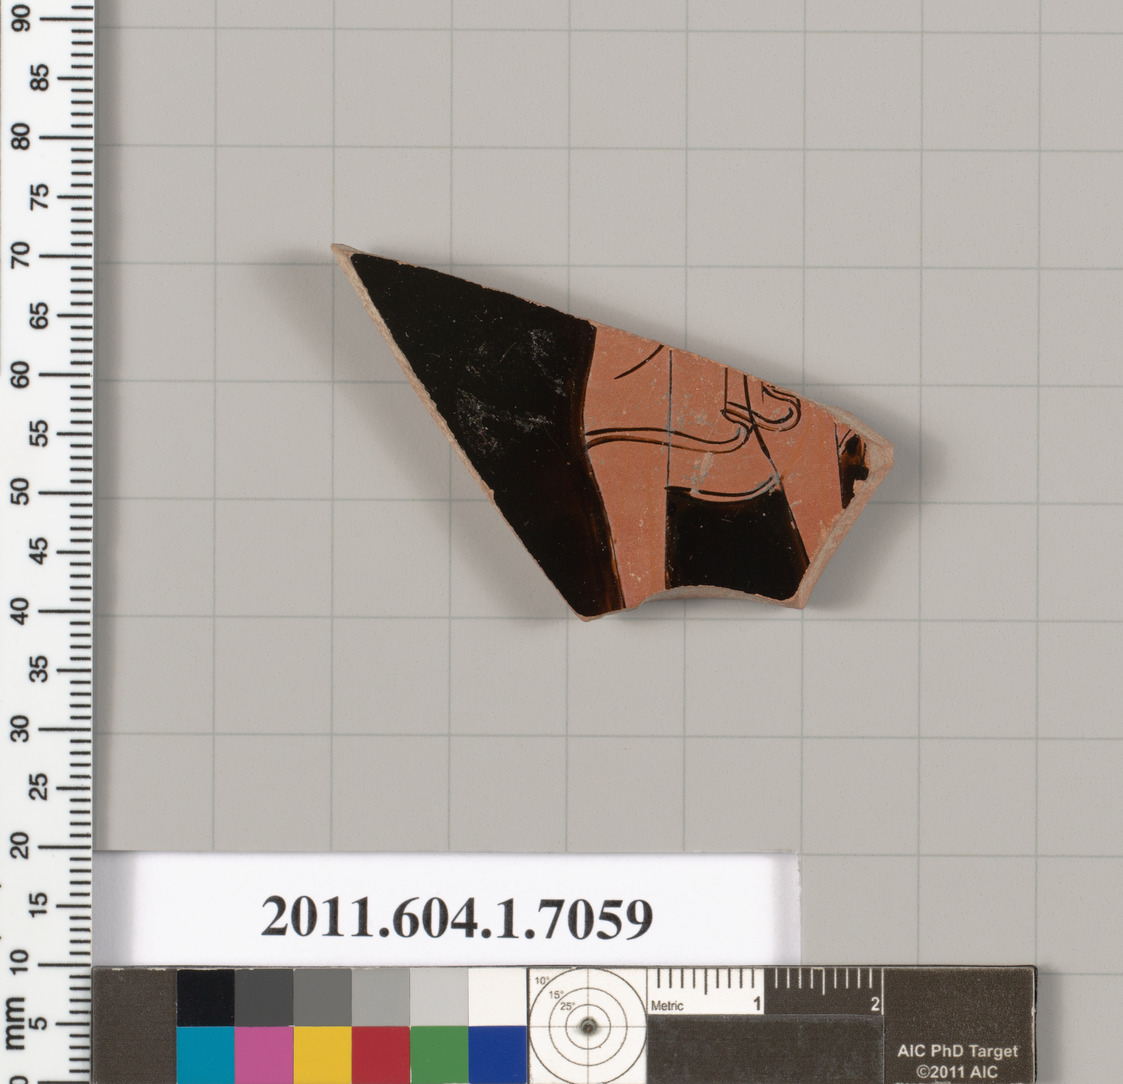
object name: kylix fragment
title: Terracotta fragment of a kylix (drinking cup)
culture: greek, attic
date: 500-480 BCE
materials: terracotta